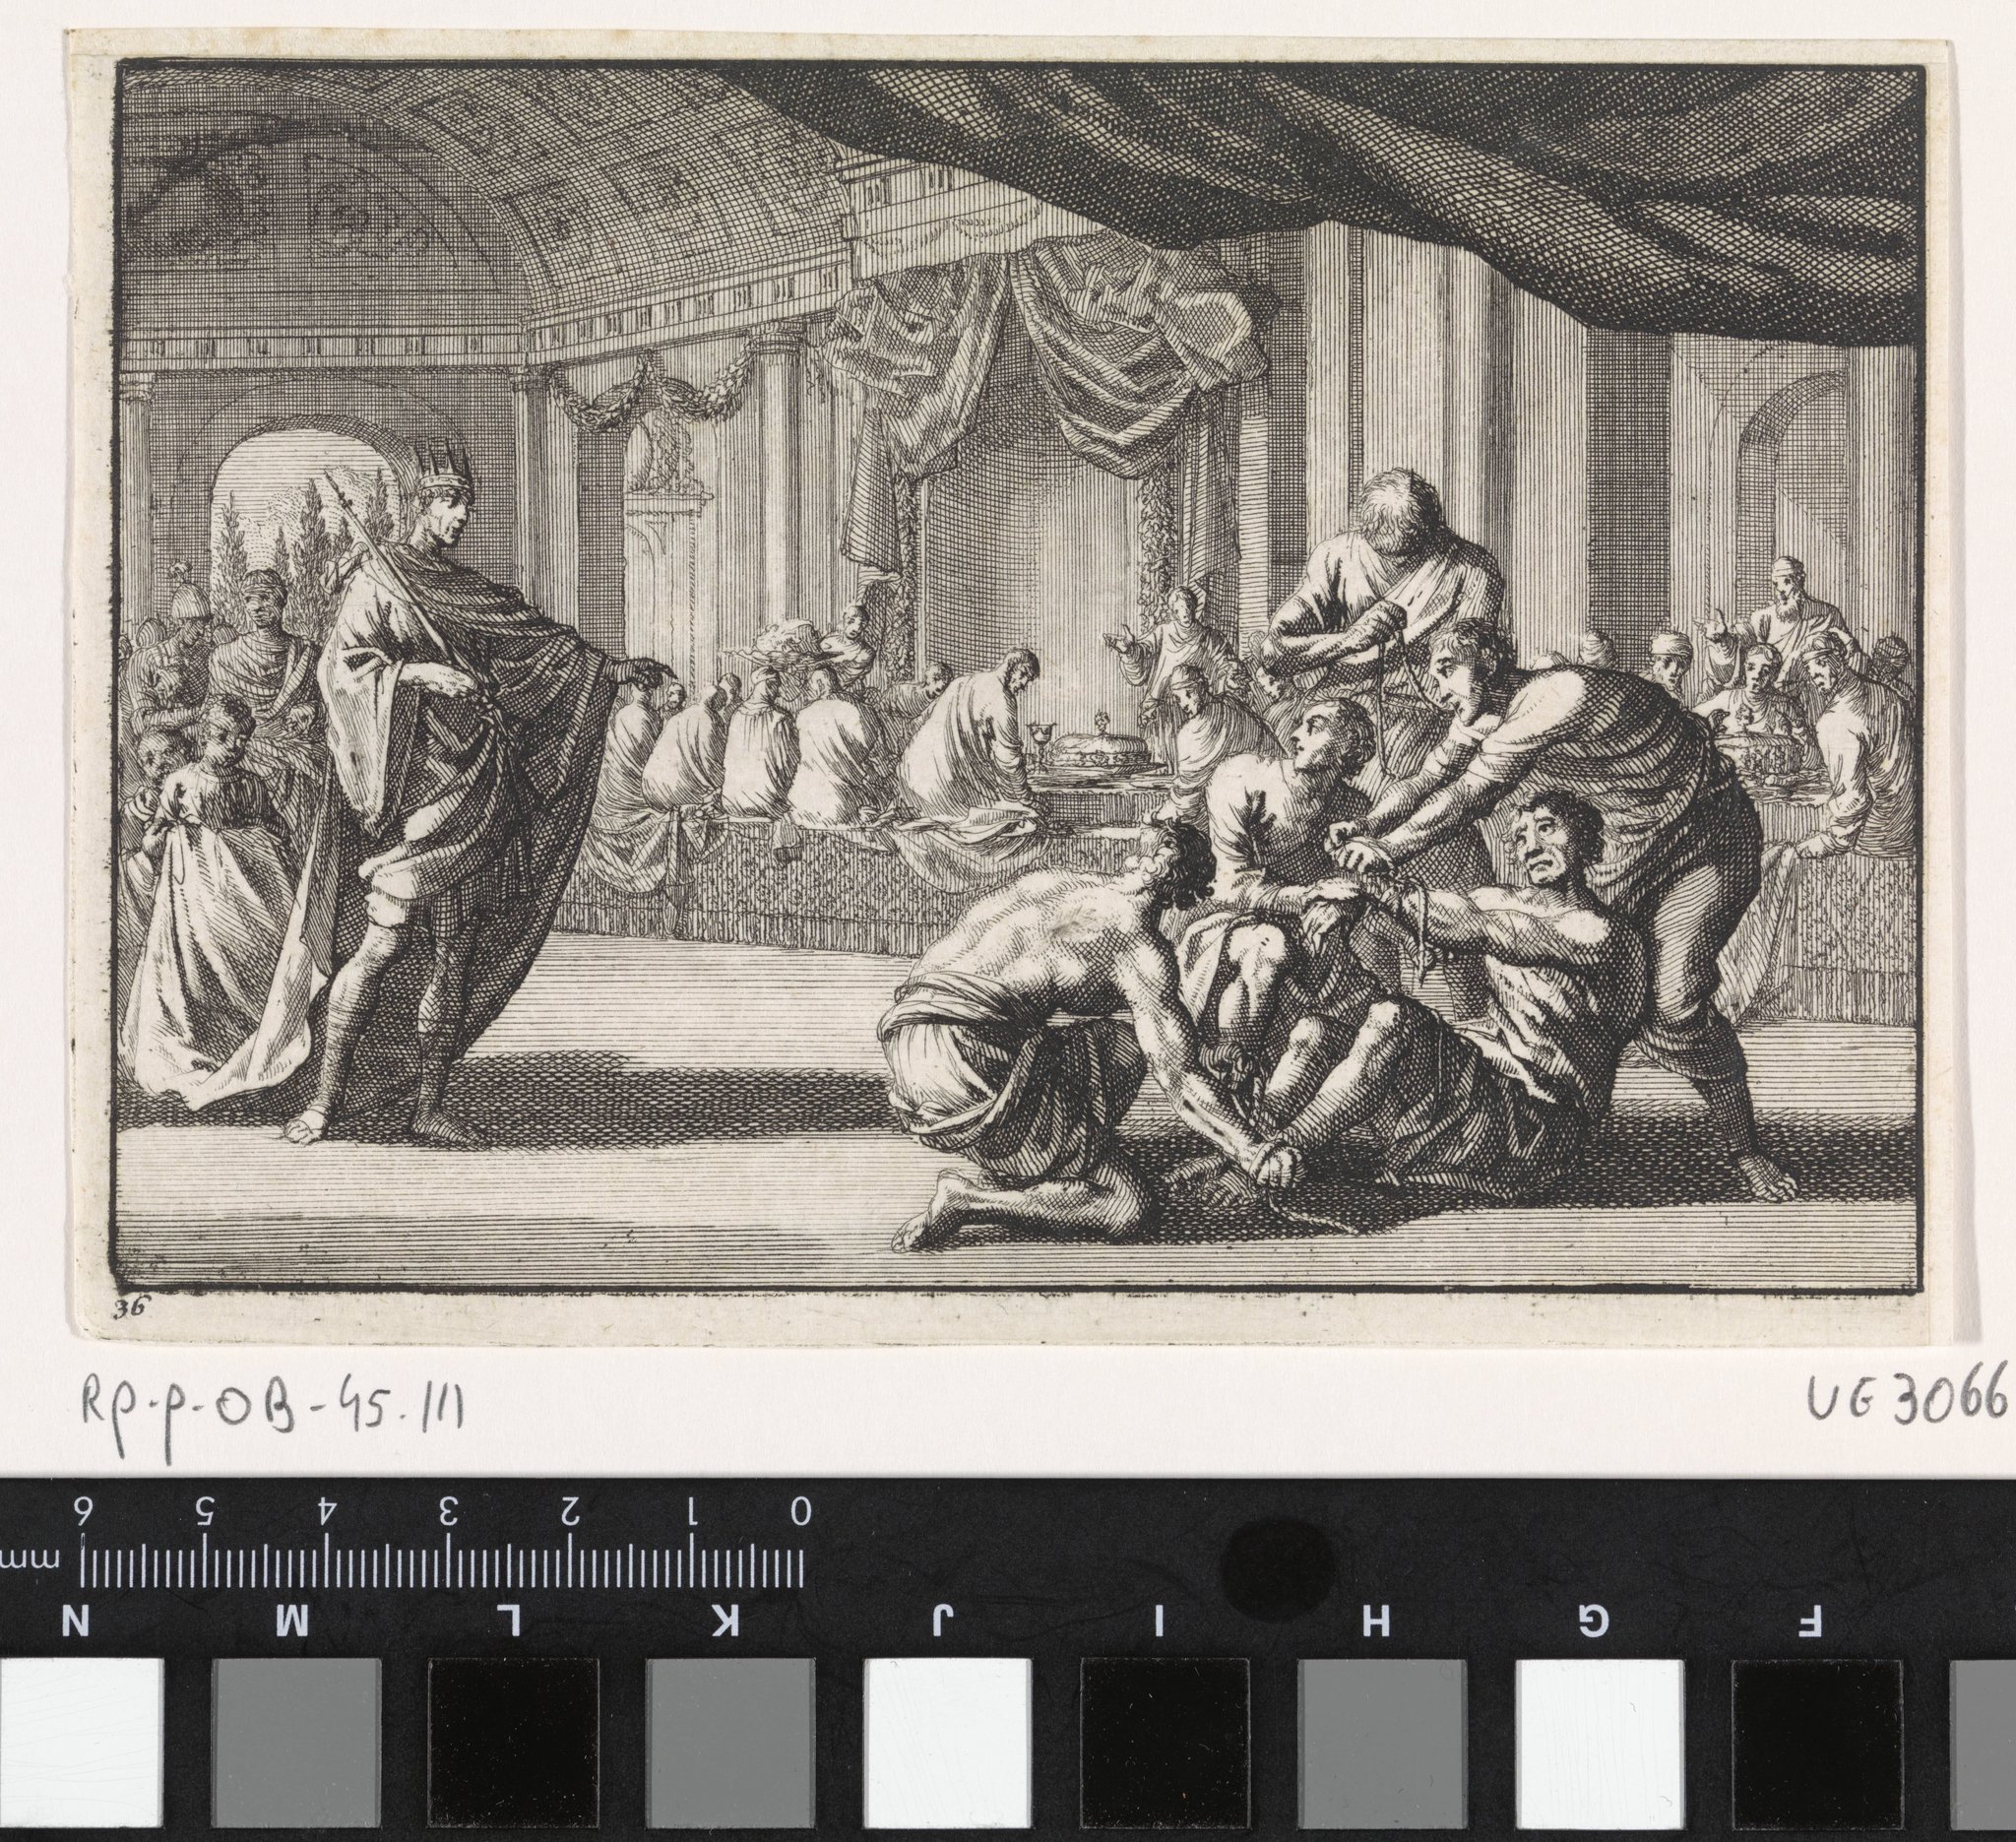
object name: print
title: Gelijkenis van de koninklijke bruiloft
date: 1703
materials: paper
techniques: etching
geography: haarlem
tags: the unworthy guest is dragged out ~ parable of the royal wedding-feast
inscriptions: collector's mark: Lugt 2228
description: Proefdruk van een boekillustratie voor David Martin. Historie des Ouden en Nieuwen Testaments. Amsterdam, Pieter Mortier, 1703. Deel II. De boekillustraties voor de Mortierbijbel hebben verschillende staten en kopieën, waarbij de chronologische volgorde moeilijk te achterhalen valt. Als boekillustraties werden ze bovendien herhaaldelijk opnieuw gebruikt voor andere boekwerken.